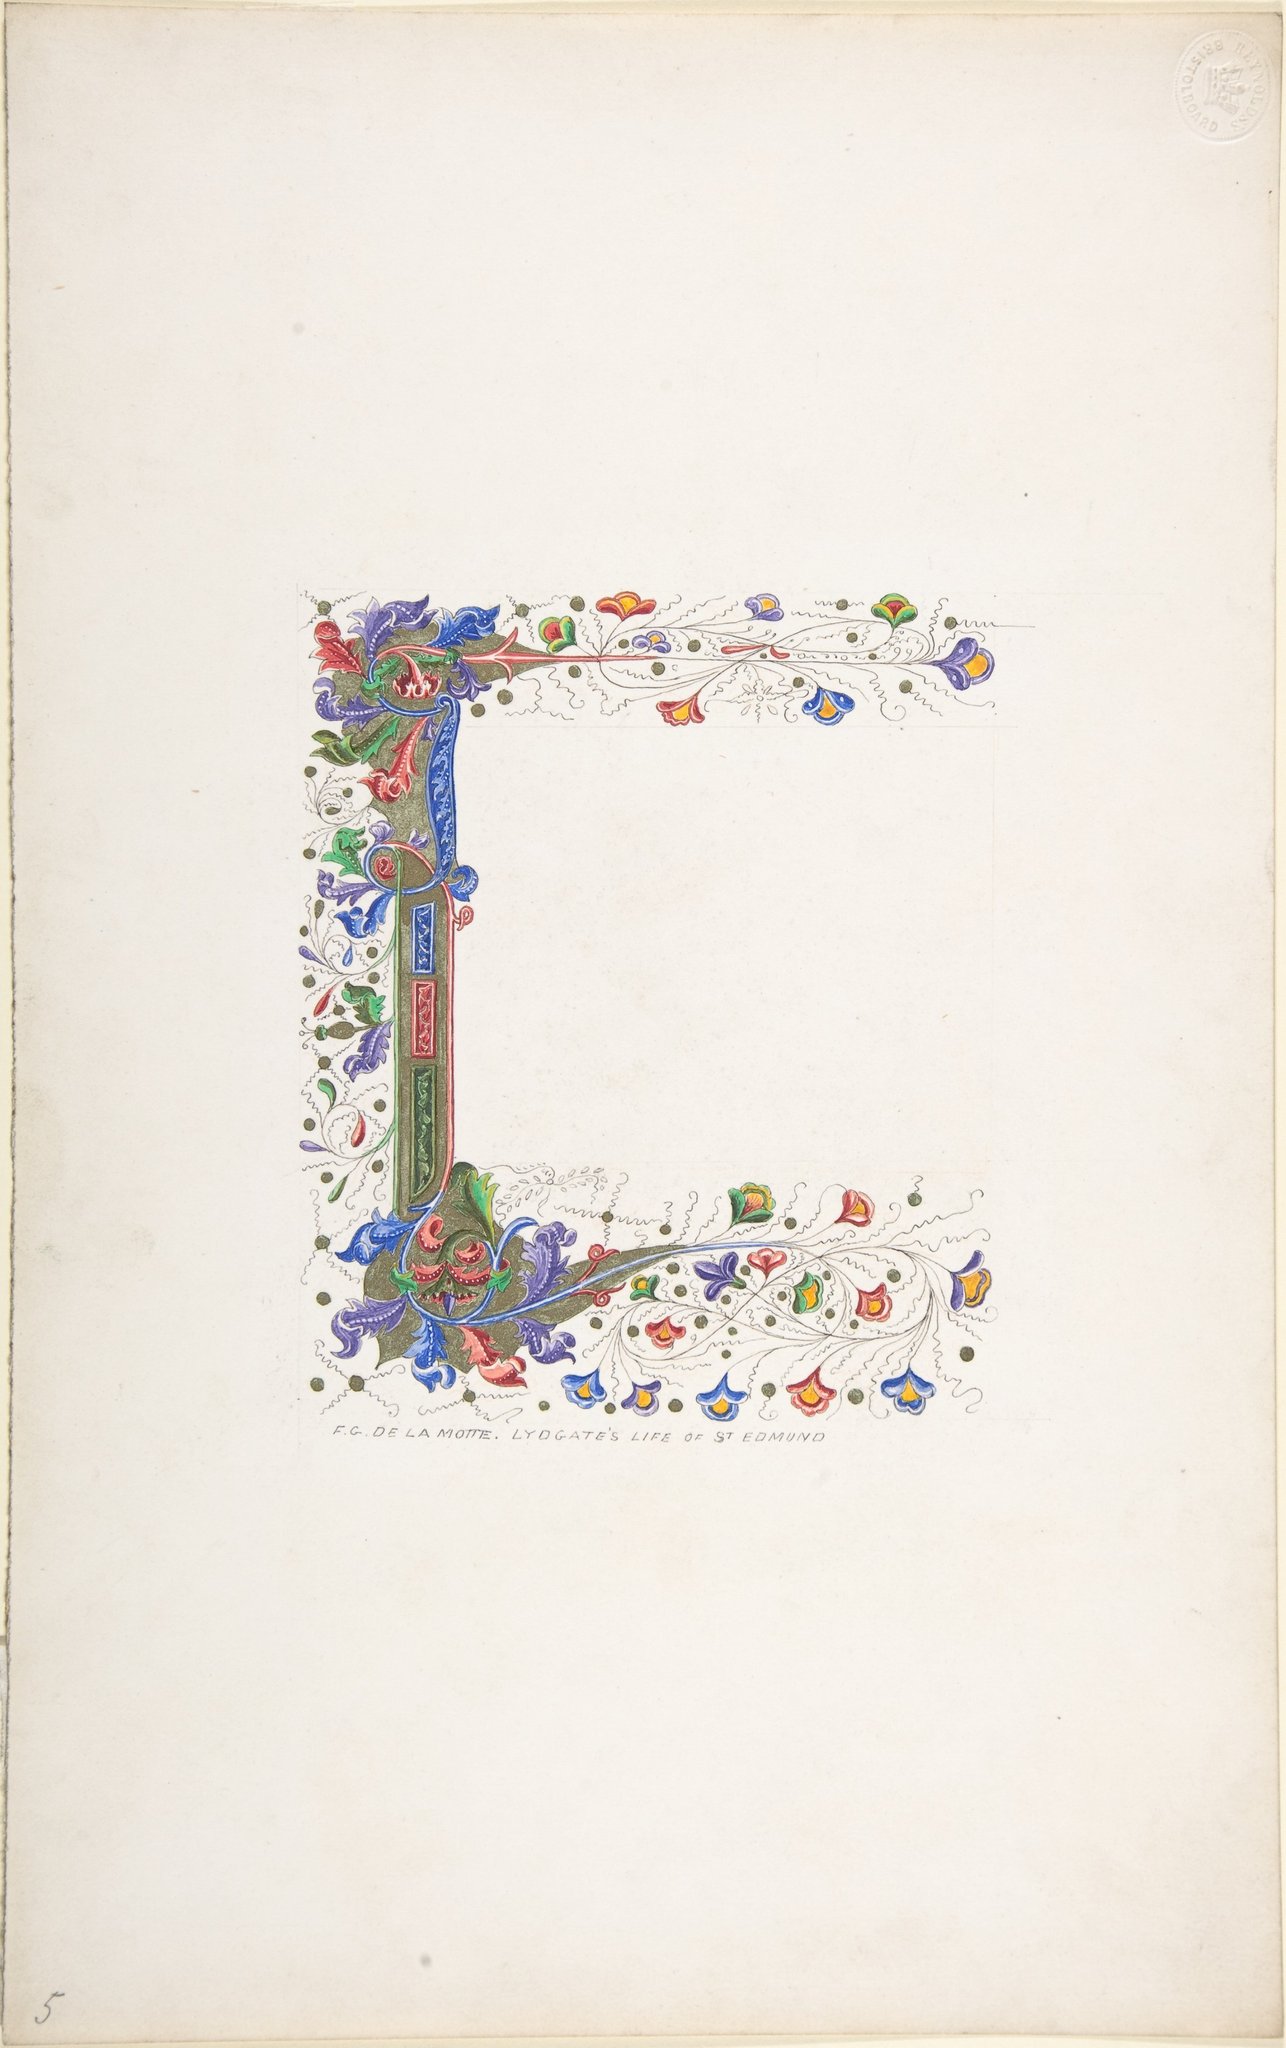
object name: drawing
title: Decorated Border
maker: freeman gage delamotte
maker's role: artist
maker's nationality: british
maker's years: 1813-1862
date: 1830-1862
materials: gouache, watercolor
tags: flowers